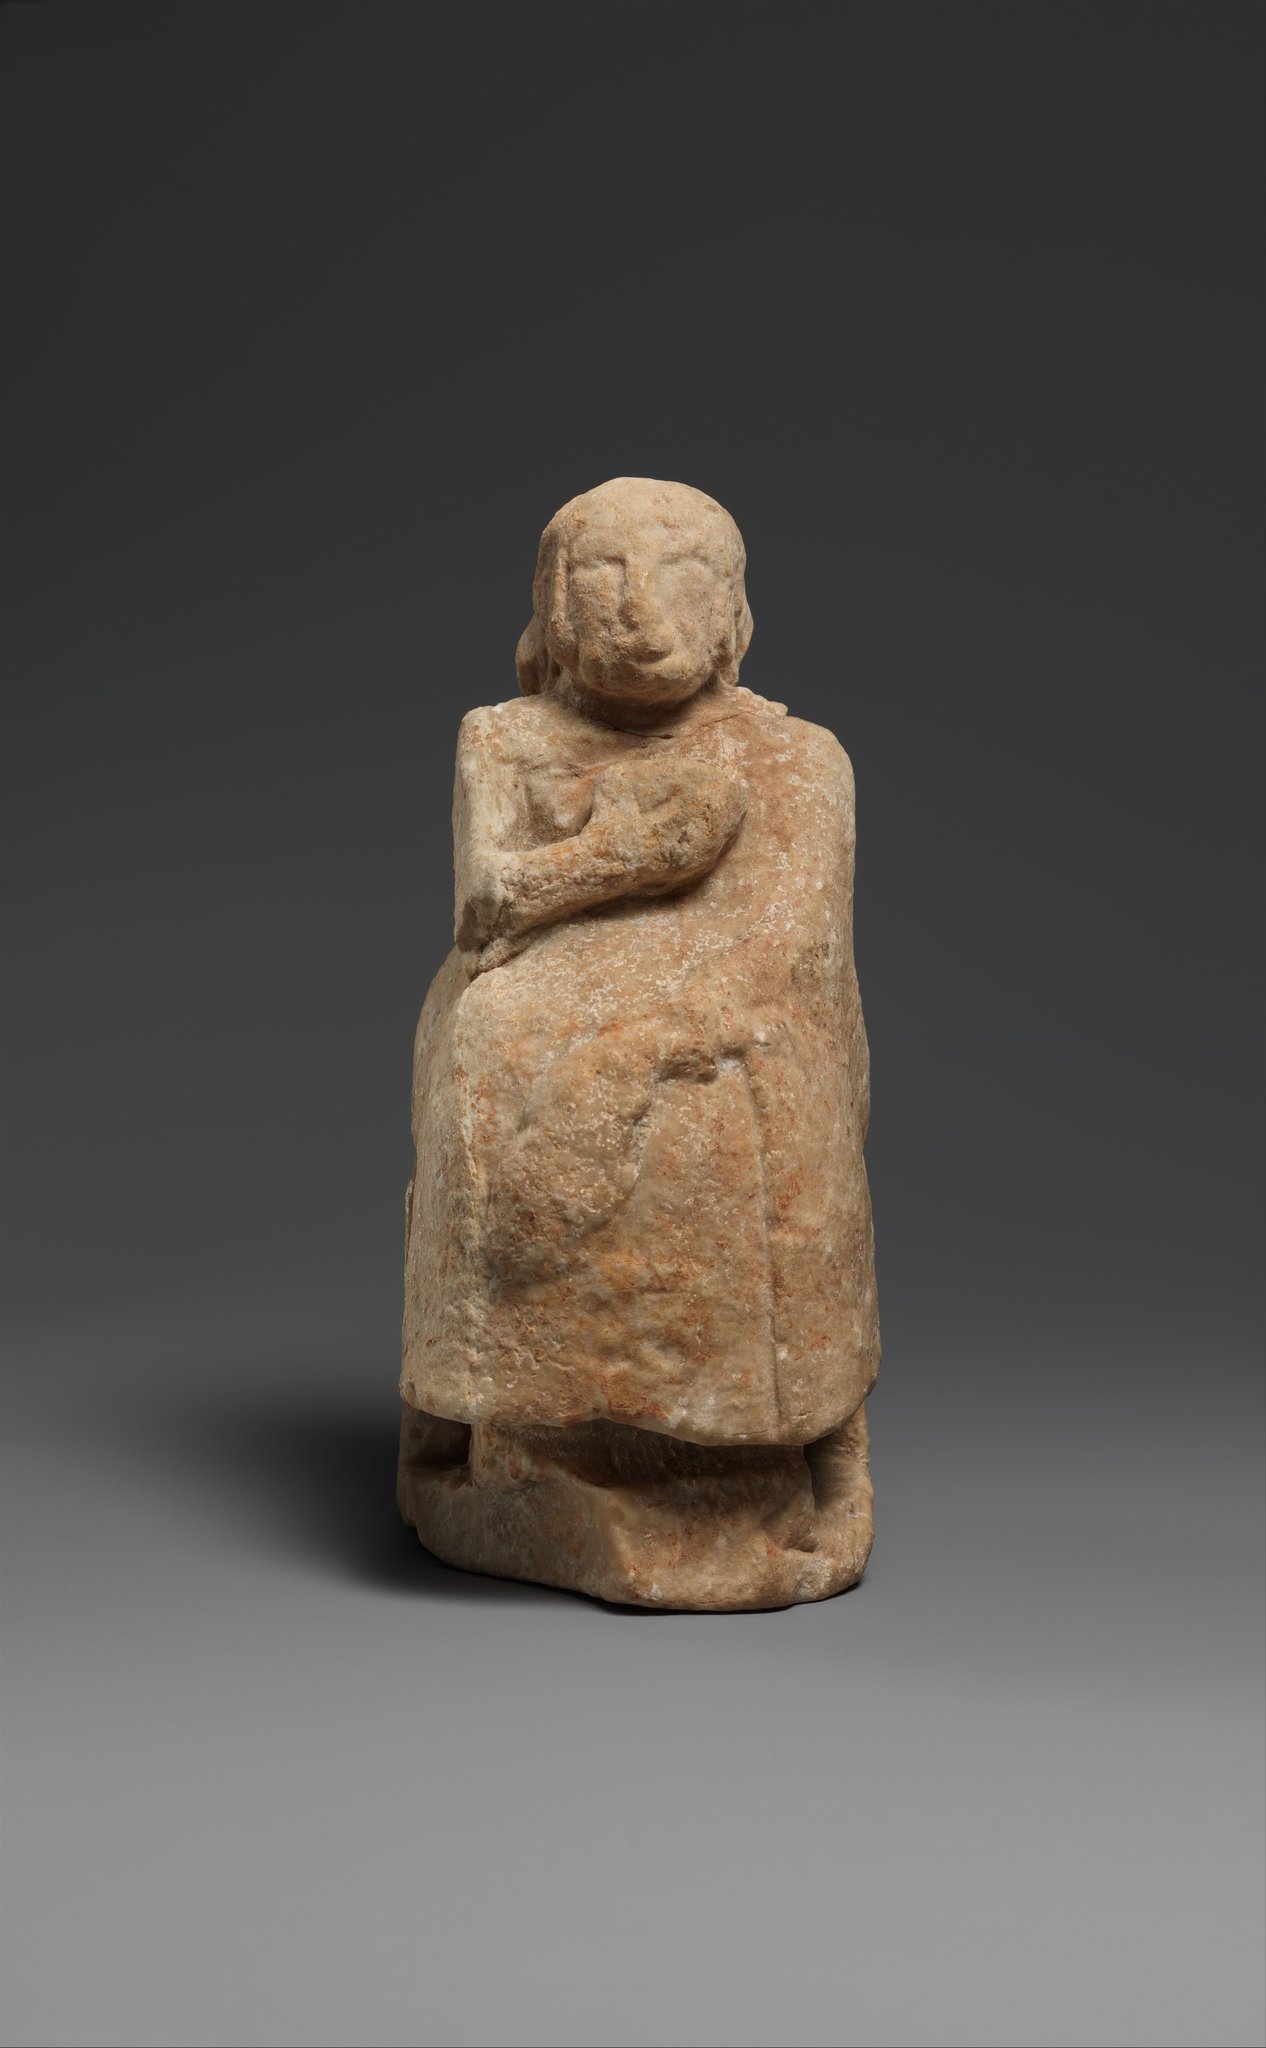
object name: sculpture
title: Seated female figure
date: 2700-2600 BCE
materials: alabaster, gypsum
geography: mesopotamia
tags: women